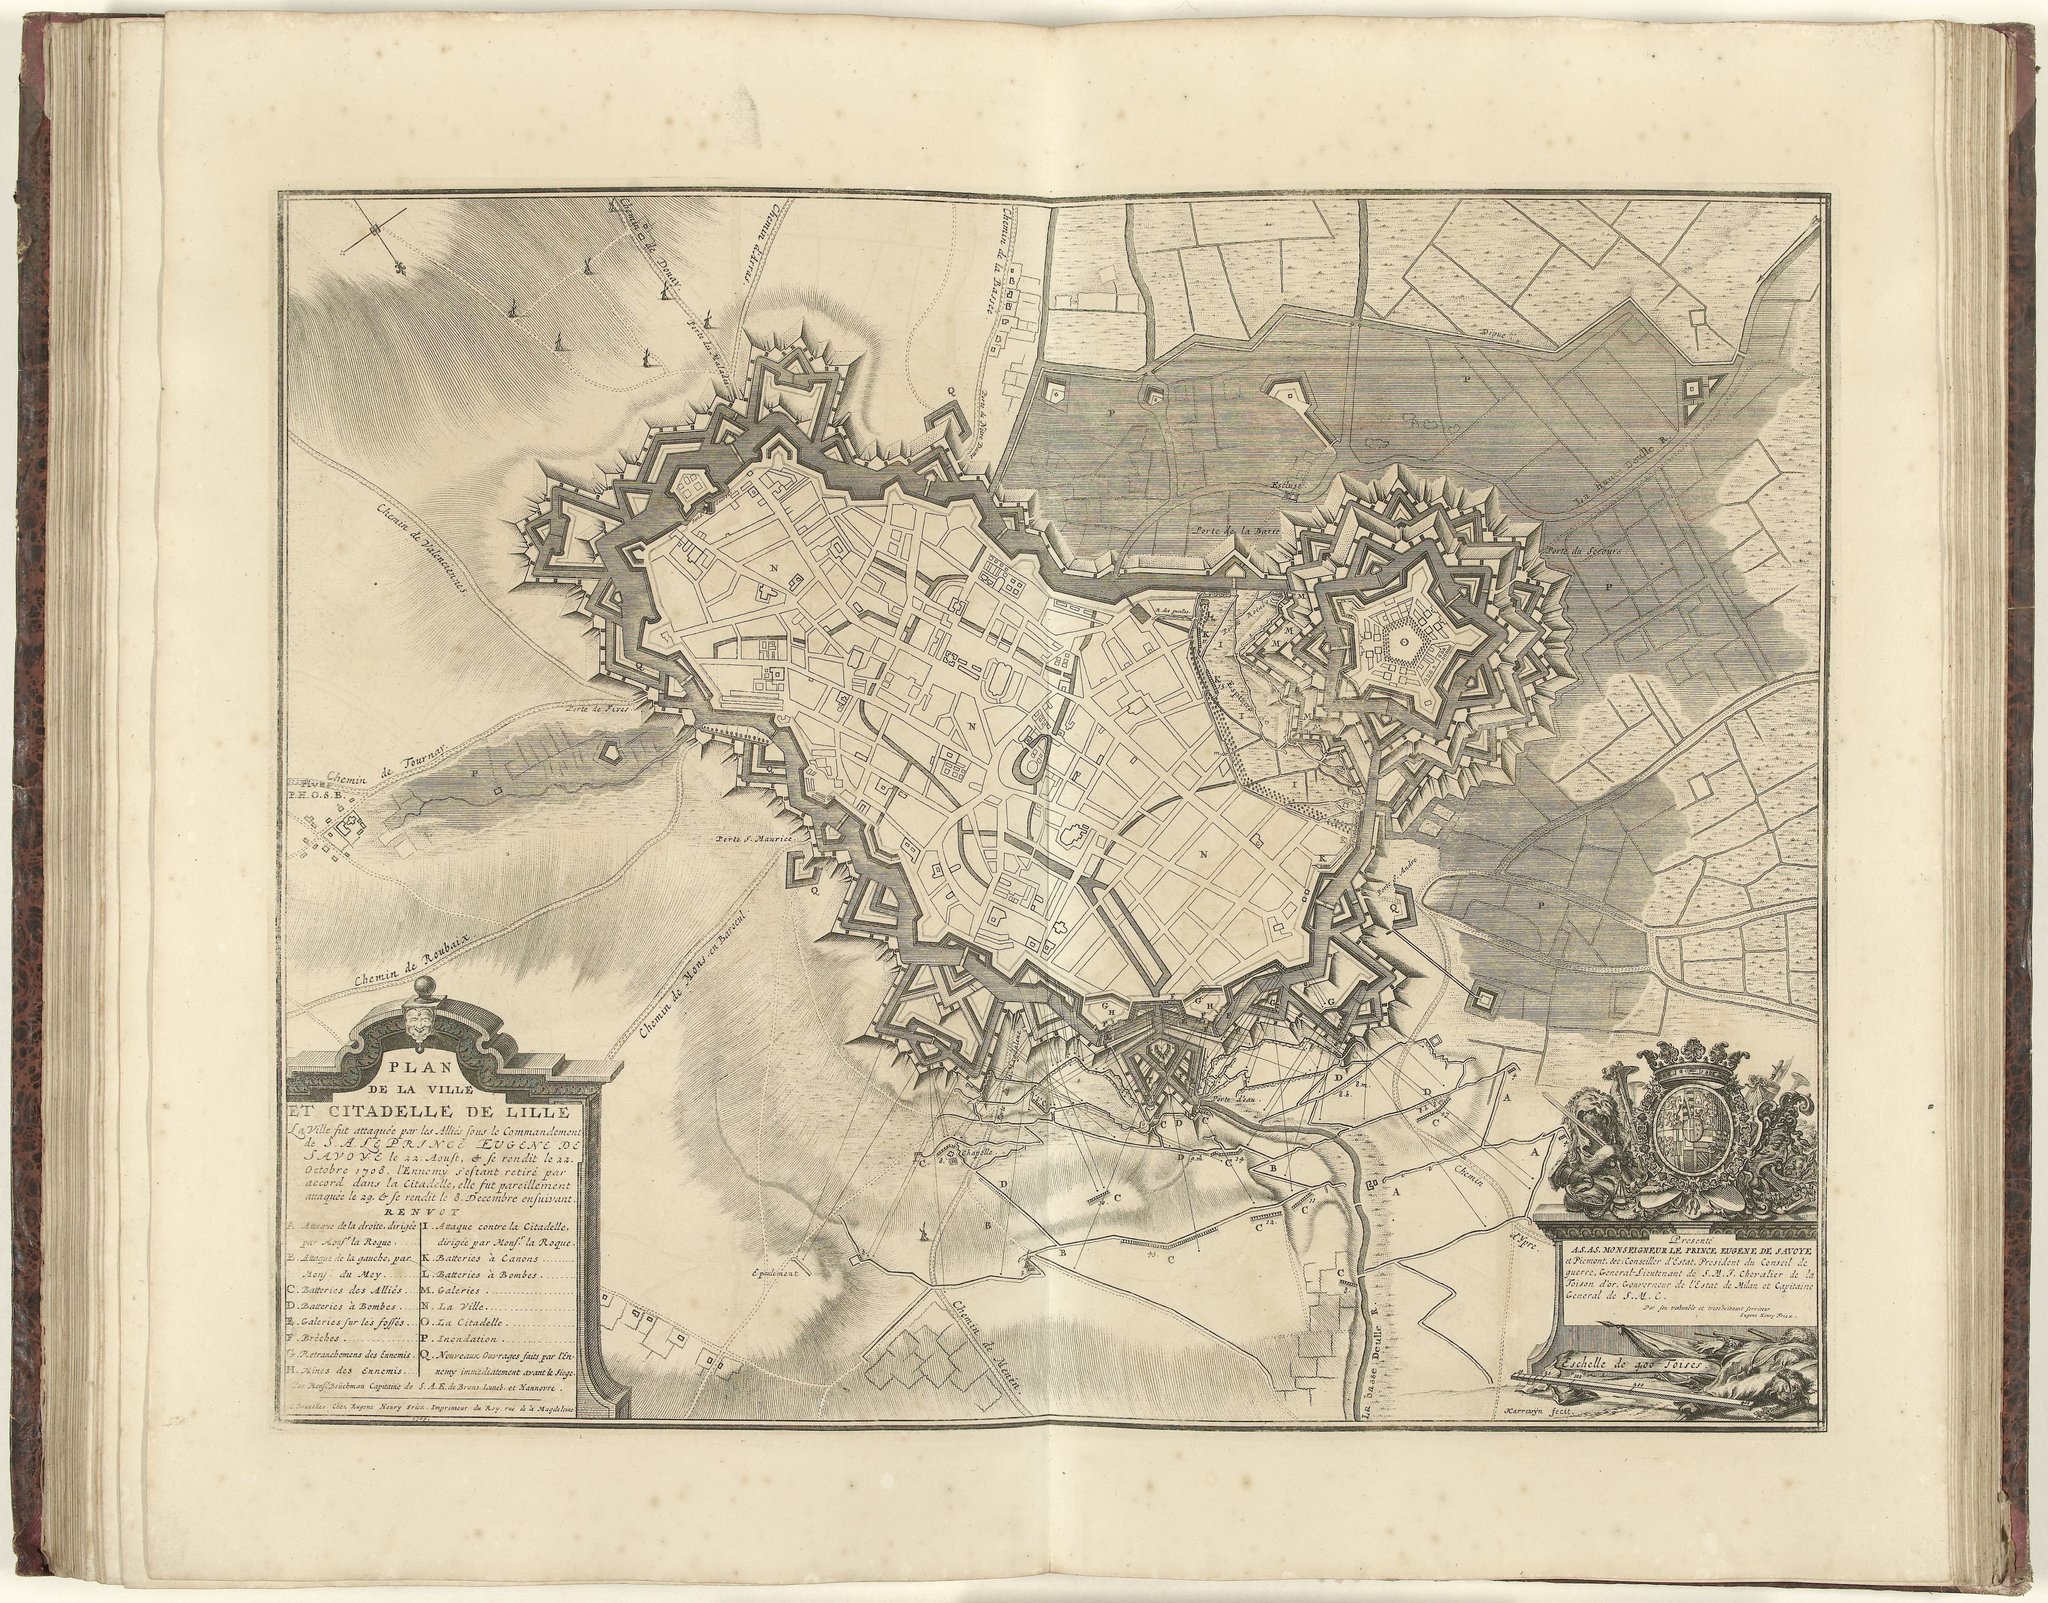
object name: print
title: Plan de la ville et citadelle de Lille La ville fut attaquée par les Alliés sous le Commandement de S.A. Le Prince Eugene de Savoye le 22. Aoust, & se rendit le 22. Octobre 1708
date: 1709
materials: paper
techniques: engraving, etching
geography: brussels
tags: paris, eugenius van savoye, siege, position war, maps of cities, lille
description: Plattegrond van de versterkingen om de stad Lille met de citadel, belegerd vanaf 22 augustus 1708 door de Geallieerden onder prins Eugenius van Savoye en ingenomen op 23 oktober, het kasteel werd op 8 december veroverd. Linksonder de titelcartouche met legenda A-Q. Rechtsonder een cartouche met de opdracht aan de prins van Savoye en zijn wapen en een schaalstok: Eschelle de 400 Toises. Onderdeel van een gebundelde verzameling van plannen van veldslagen en steden vermaard in de Spaanse Successieoorlog.